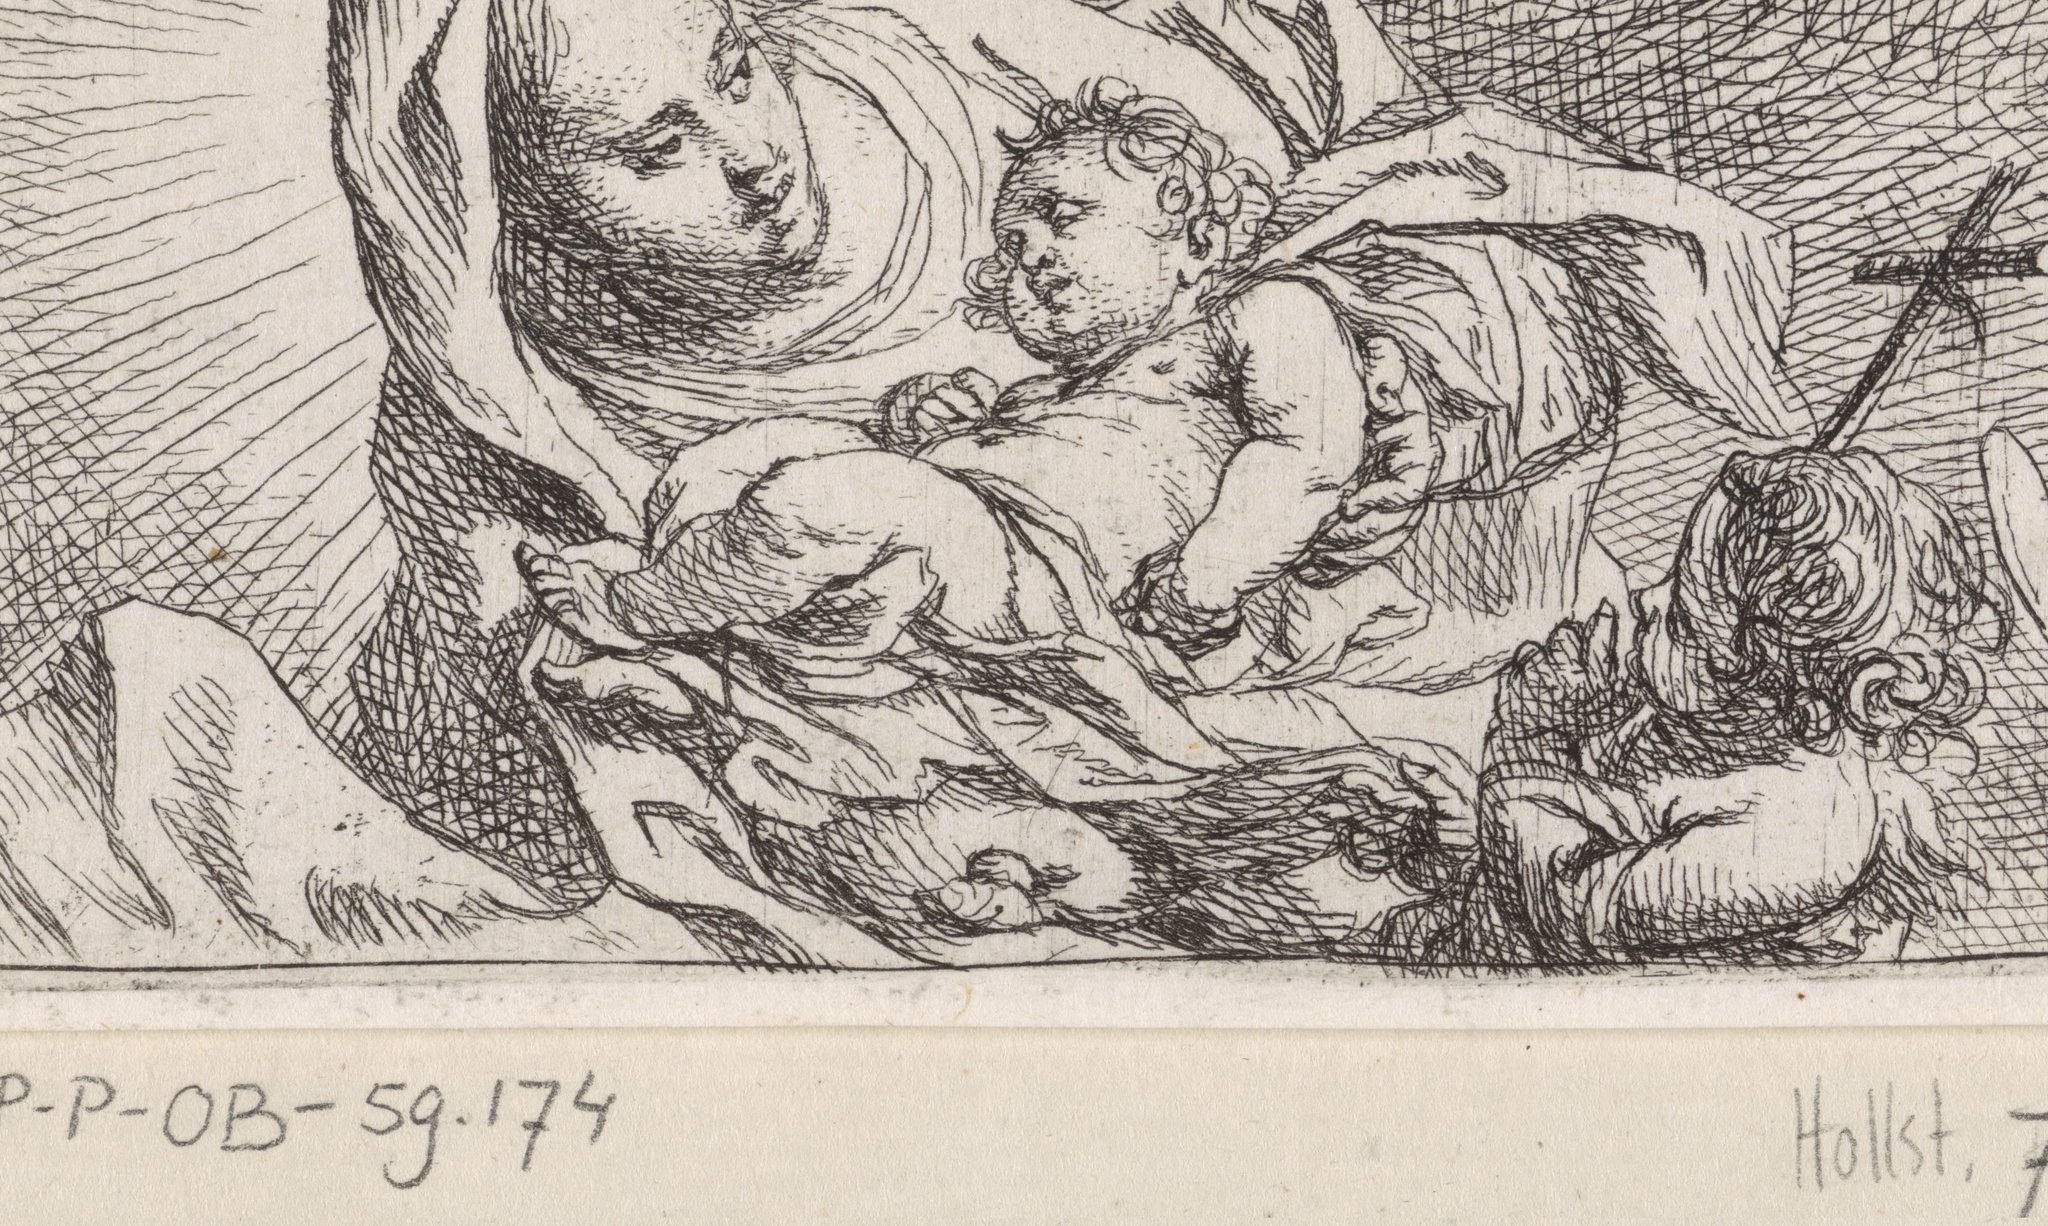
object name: print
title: Madonna met Kind en Johannes de Doper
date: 1618-1655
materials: paper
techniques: etching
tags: mary and the christ-child with john the baptist (as child)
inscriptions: collector's mark: Lugt 240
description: Maria houdt het slapende Christuskind in haar armen. Aan haar voeten staat de jonge Johannes de Doper die een kruis vasthoudt.